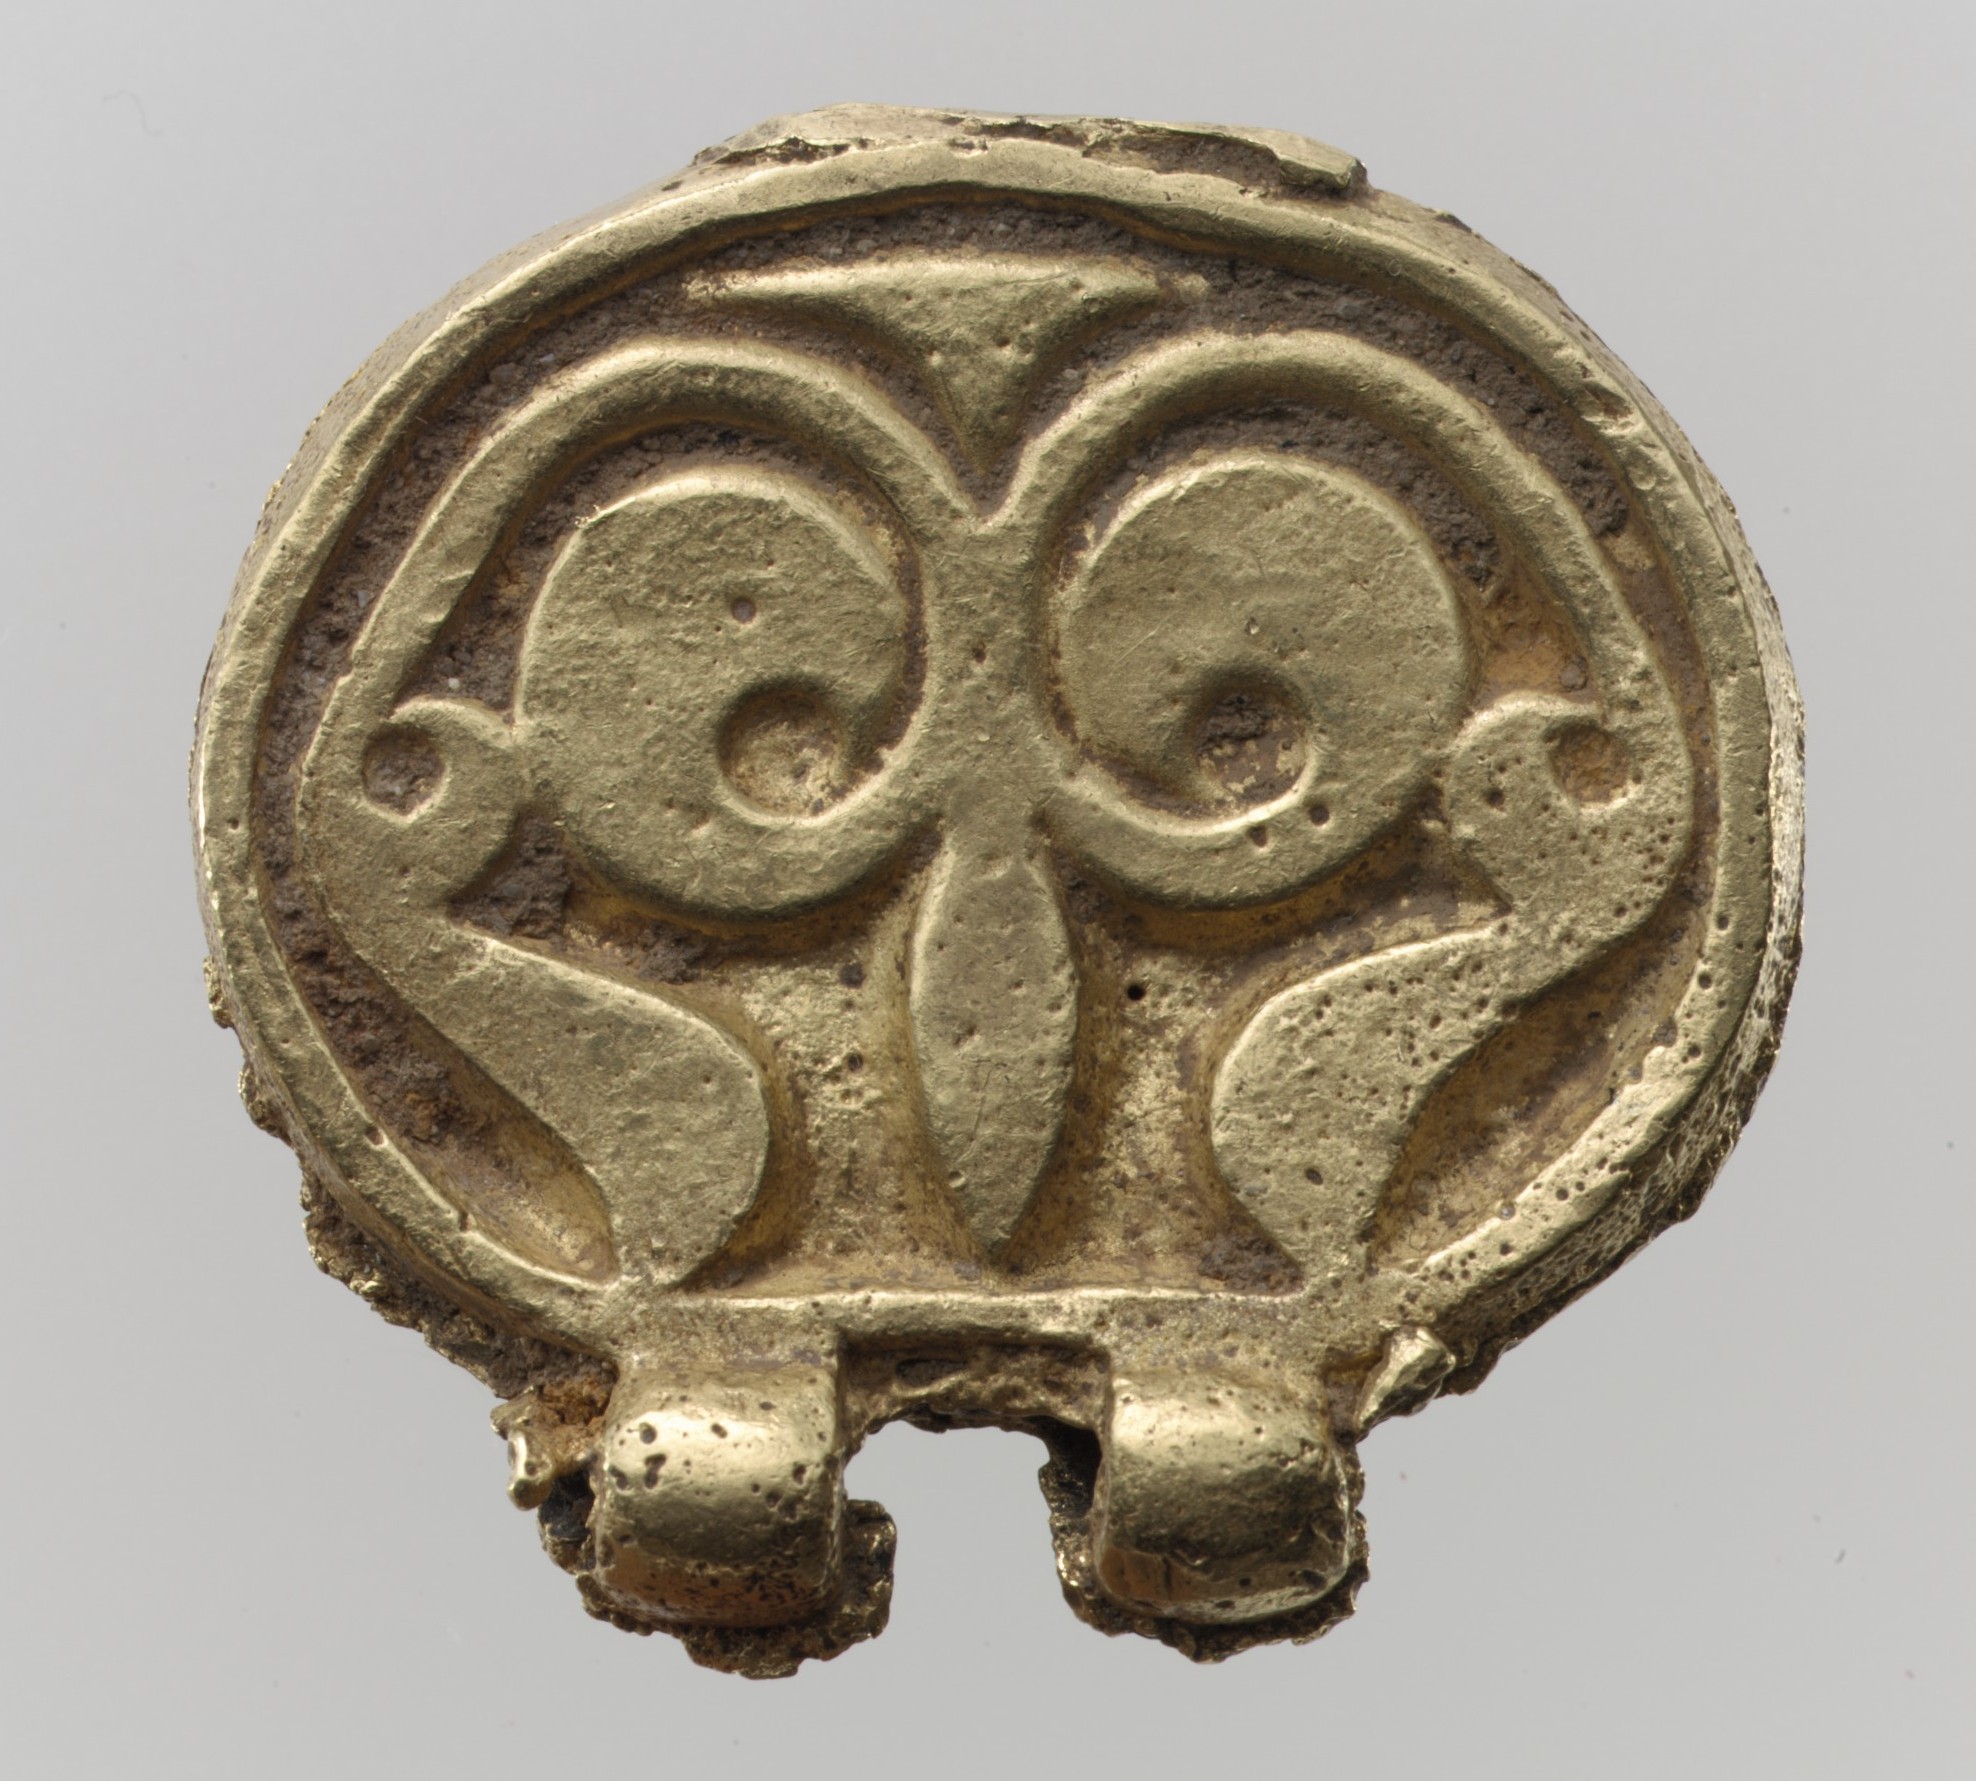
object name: belt mount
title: Gold Belt Mount (Miscast and Unfinished)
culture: avar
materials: gold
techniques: casting